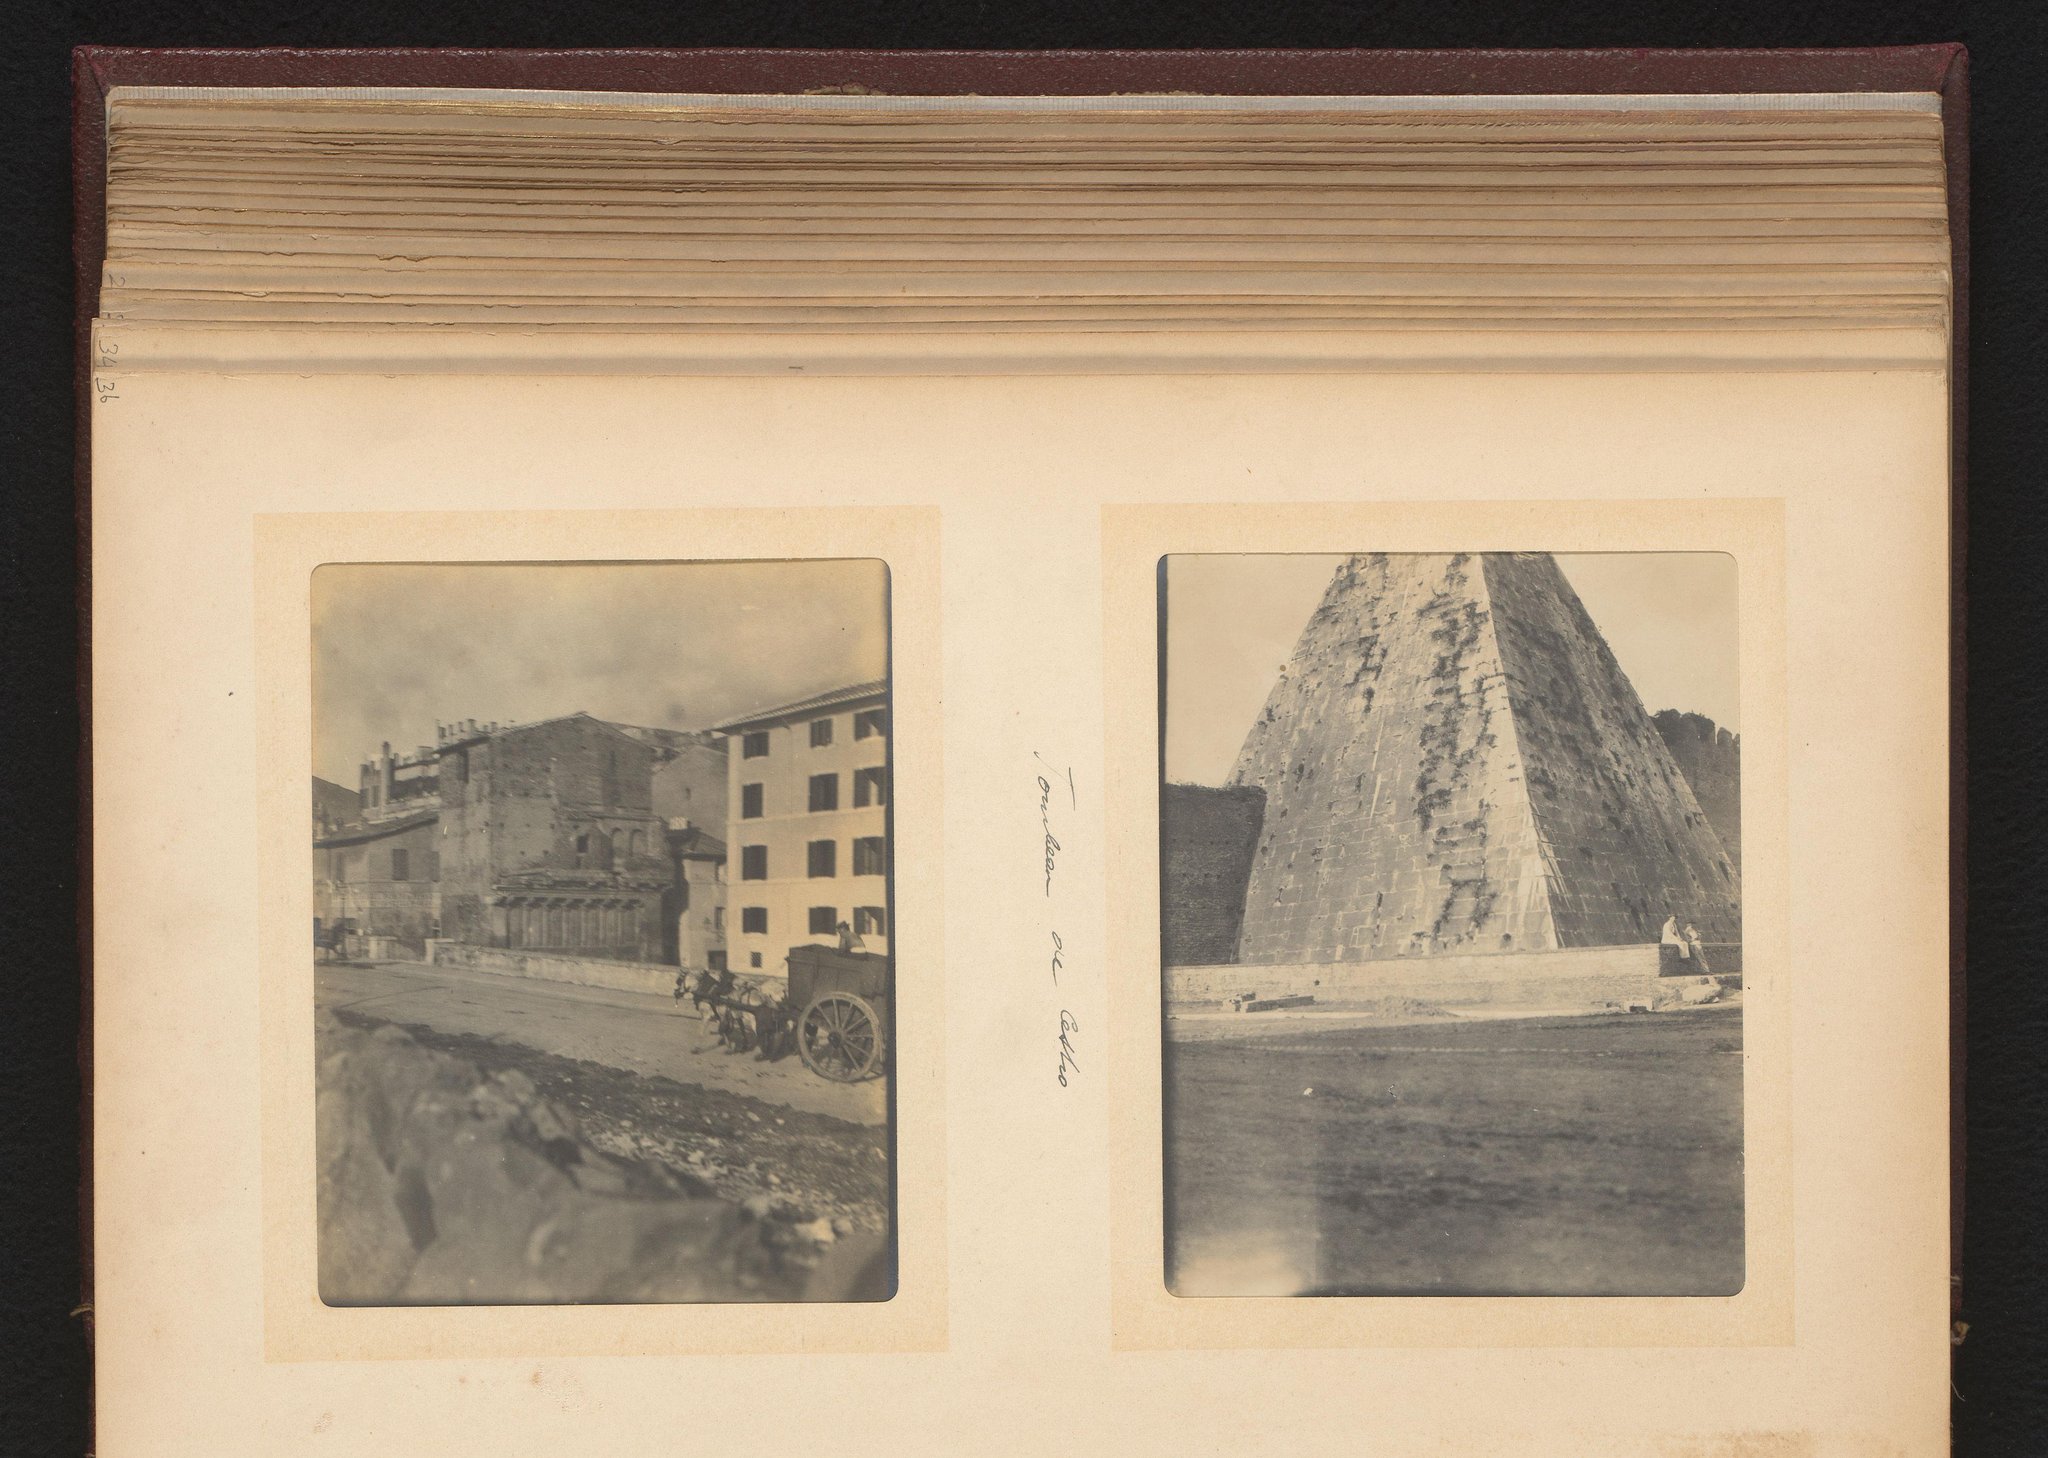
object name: album leaf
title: Piramide van Cestius en straatgezicht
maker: Anonymous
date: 1895-1905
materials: cardboard, photographic support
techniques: gelatin silver print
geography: rome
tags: tourism, grave, tomb, pyramid (marking grave), street (+ city(-scape) with figures, staffage), rome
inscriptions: inscription: ‘Tombeau de Cestio’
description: Albumblad met twee foto's in Rome. Onderdeel van een fotoalbum van een reis door Italië, ca. 1900.